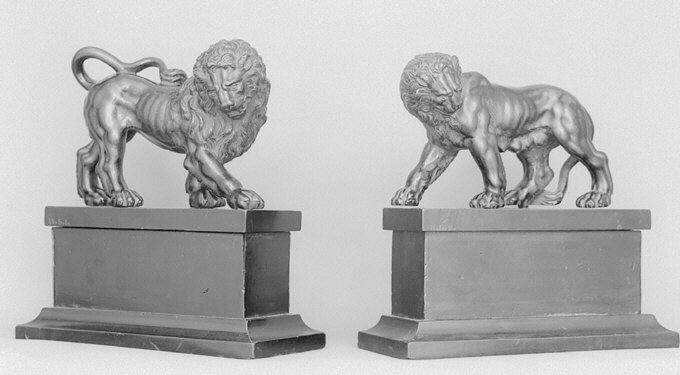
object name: statuette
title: Lioness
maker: giovanni francesco susini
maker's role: artist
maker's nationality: italian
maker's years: 1585-1653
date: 1601-1800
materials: bronze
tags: lions